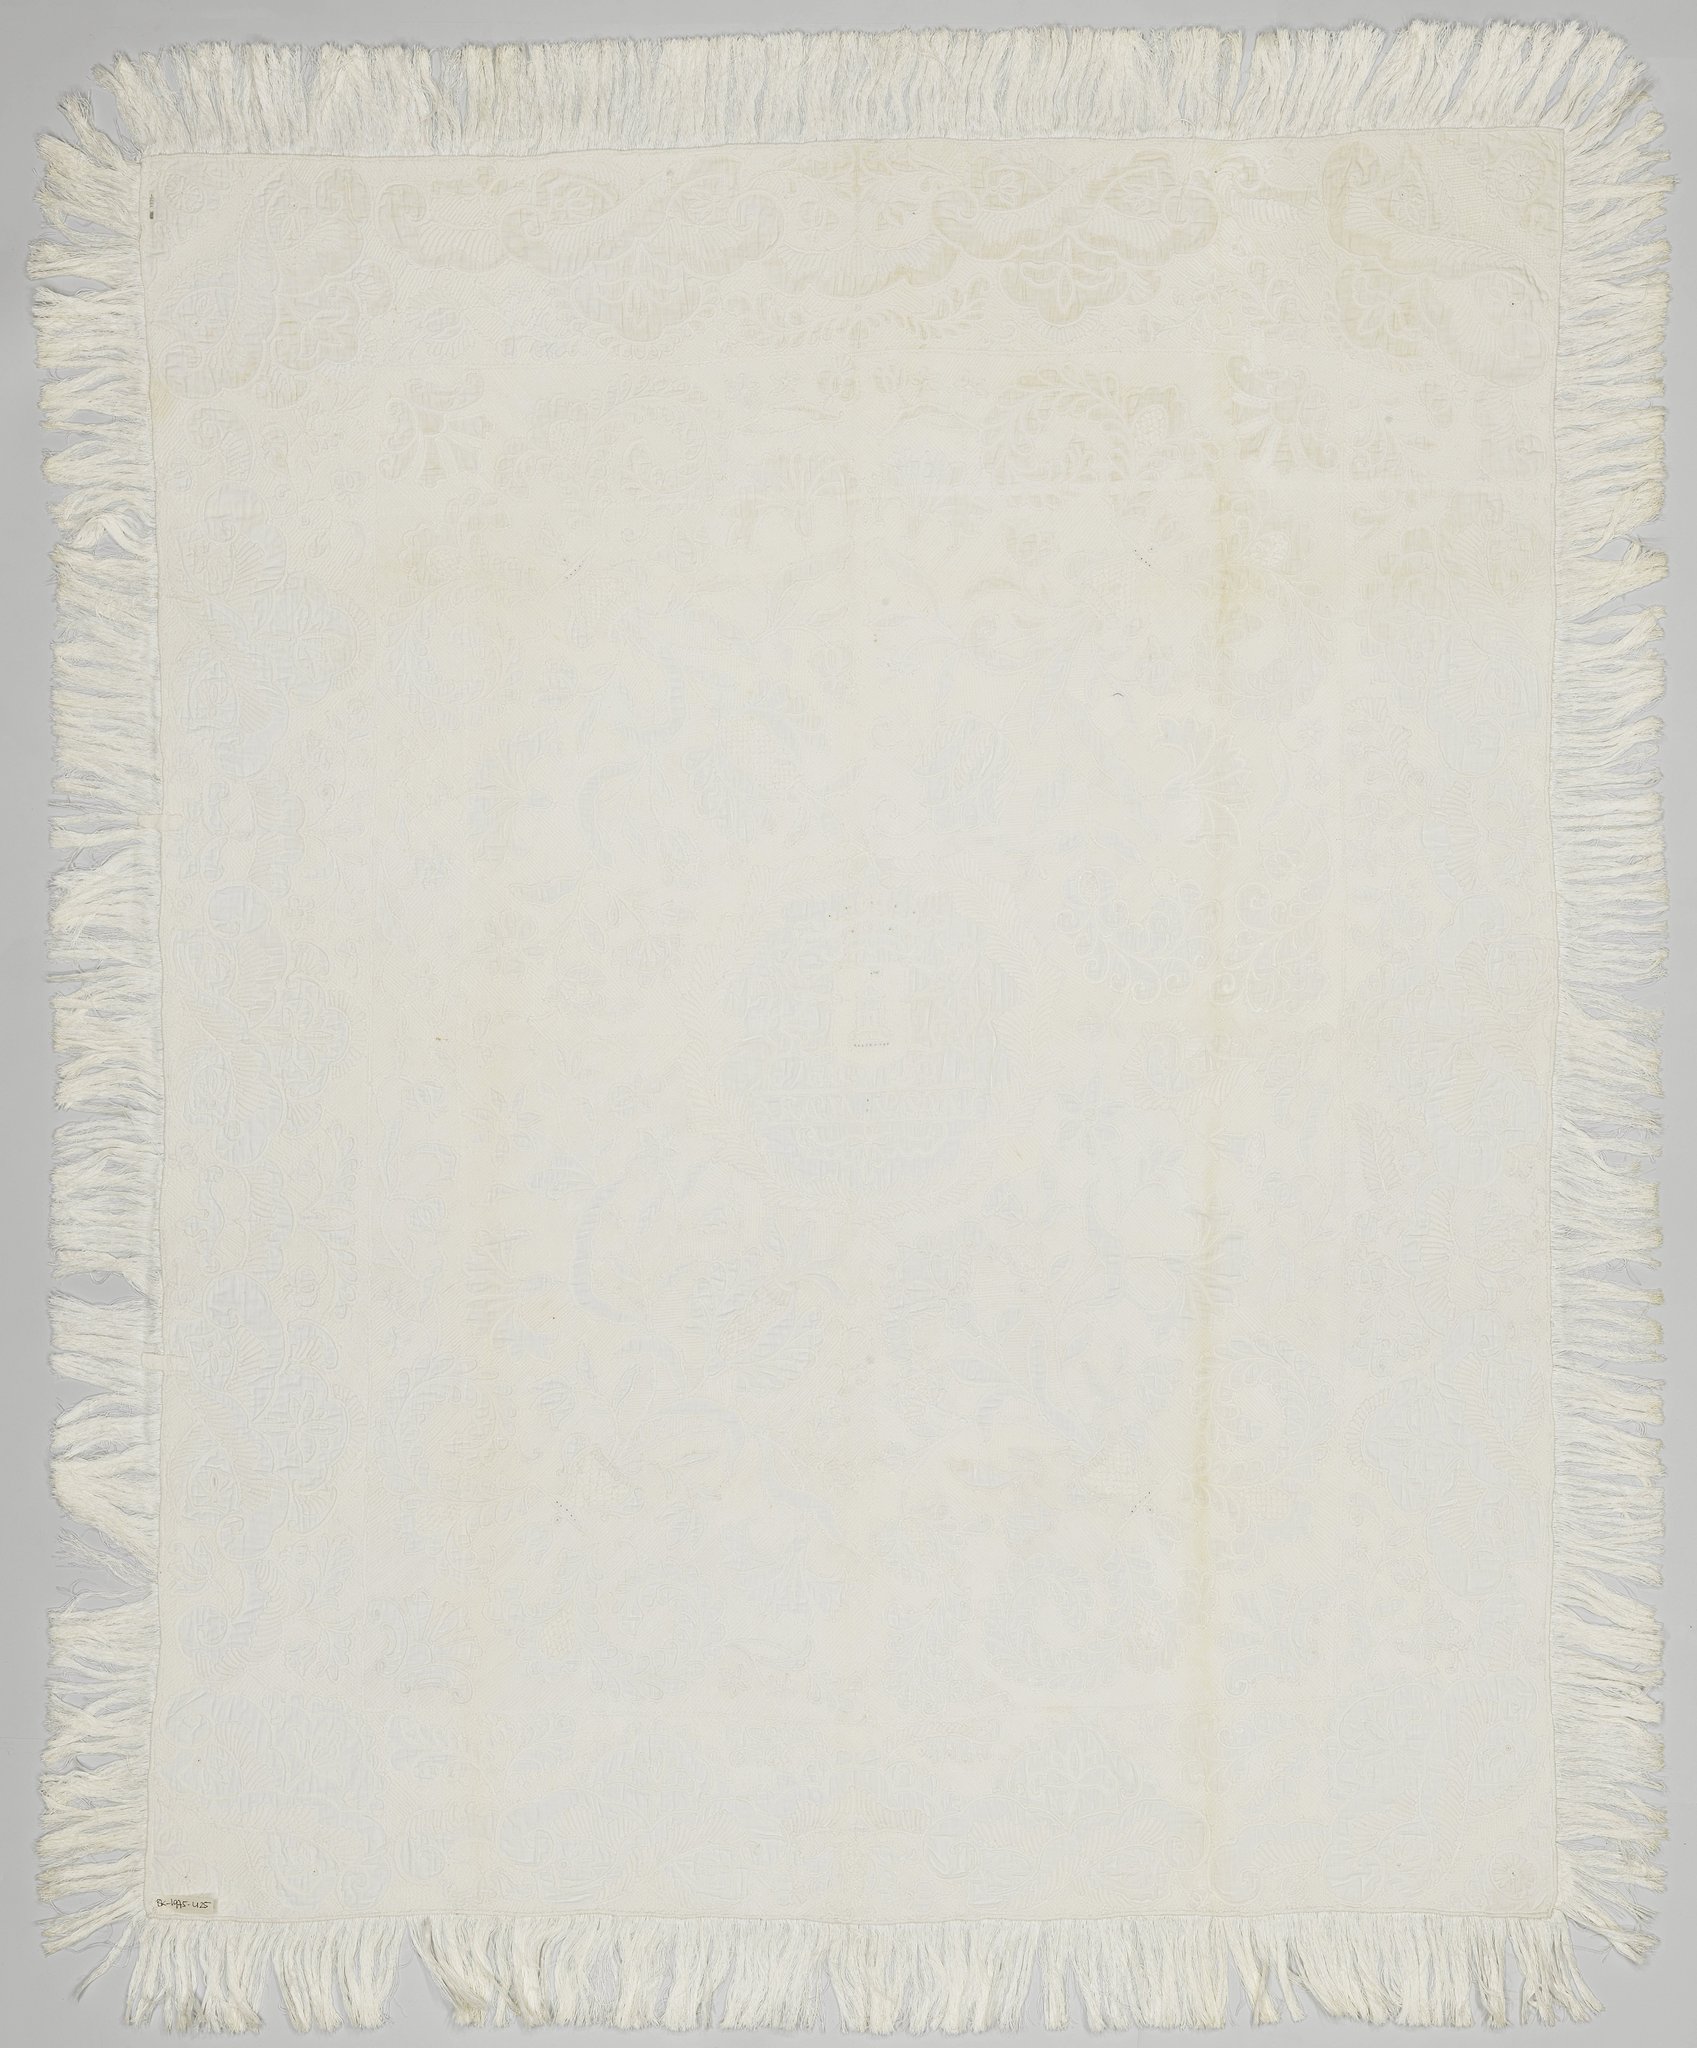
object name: kleed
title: Kleed van witte katoen met in Zaans stikwerk o.a. het wapen De Veije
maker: Anonymous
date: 1763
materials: cotton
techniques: embroidered, quilting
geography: northern netherlands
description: Kleed van witte katoen met Zaans stikwerk en met franje rondom. Randen met ornamenten en bloemen, in het midden uit vazen uitwaaierende bloemtakken en, binnen palmtakken, het wapen De Veije en de initialen IPDV en MDR (Isaac Petrus de Veije (1733-1818) en Maria de Ruijter (1743-1797), gehuwd in 1763.